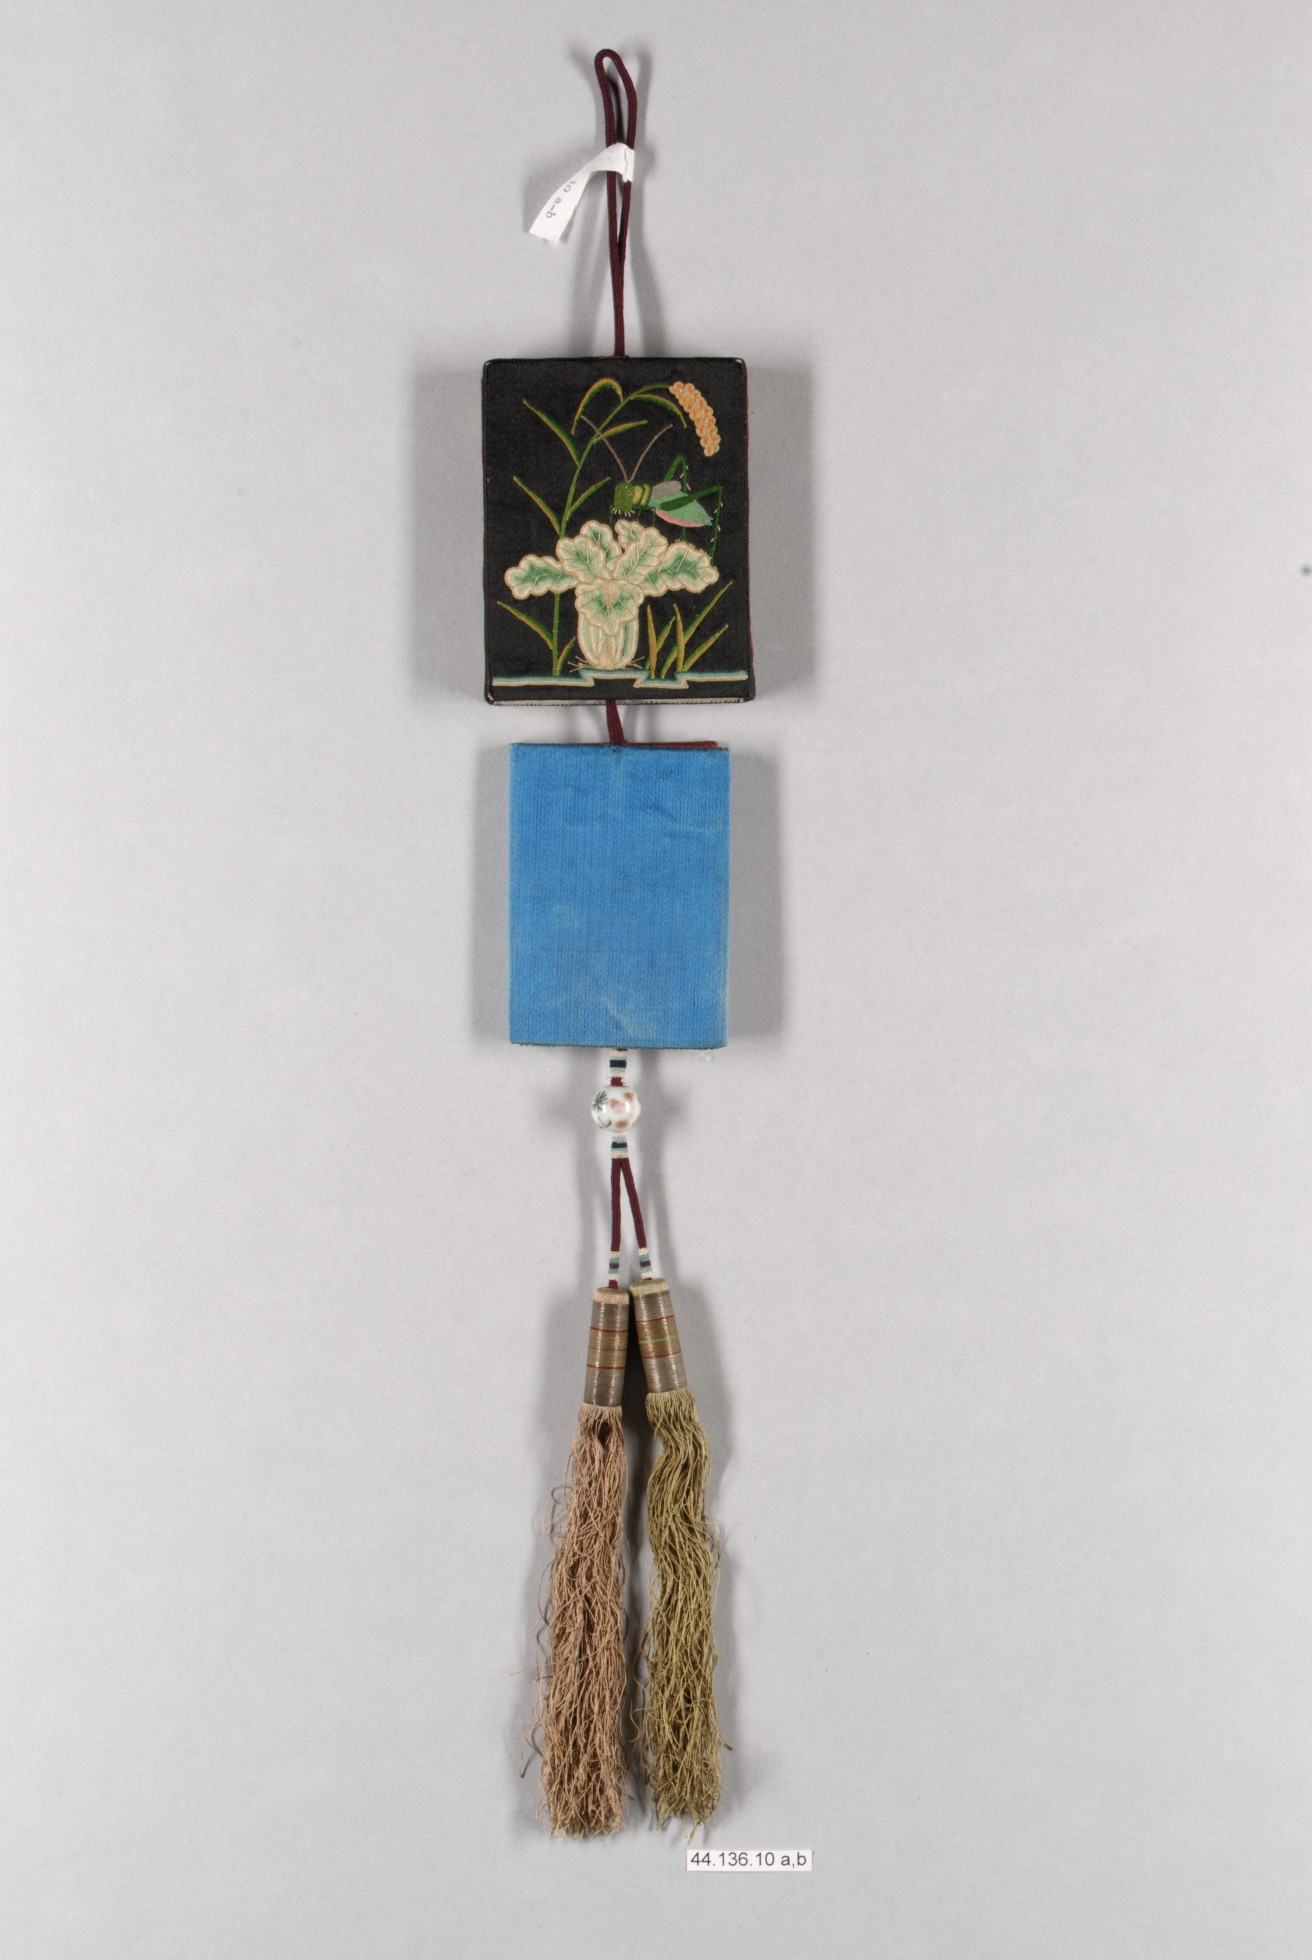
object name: mirror and needlecase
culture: chinese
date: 1644-1911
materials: glass, silk